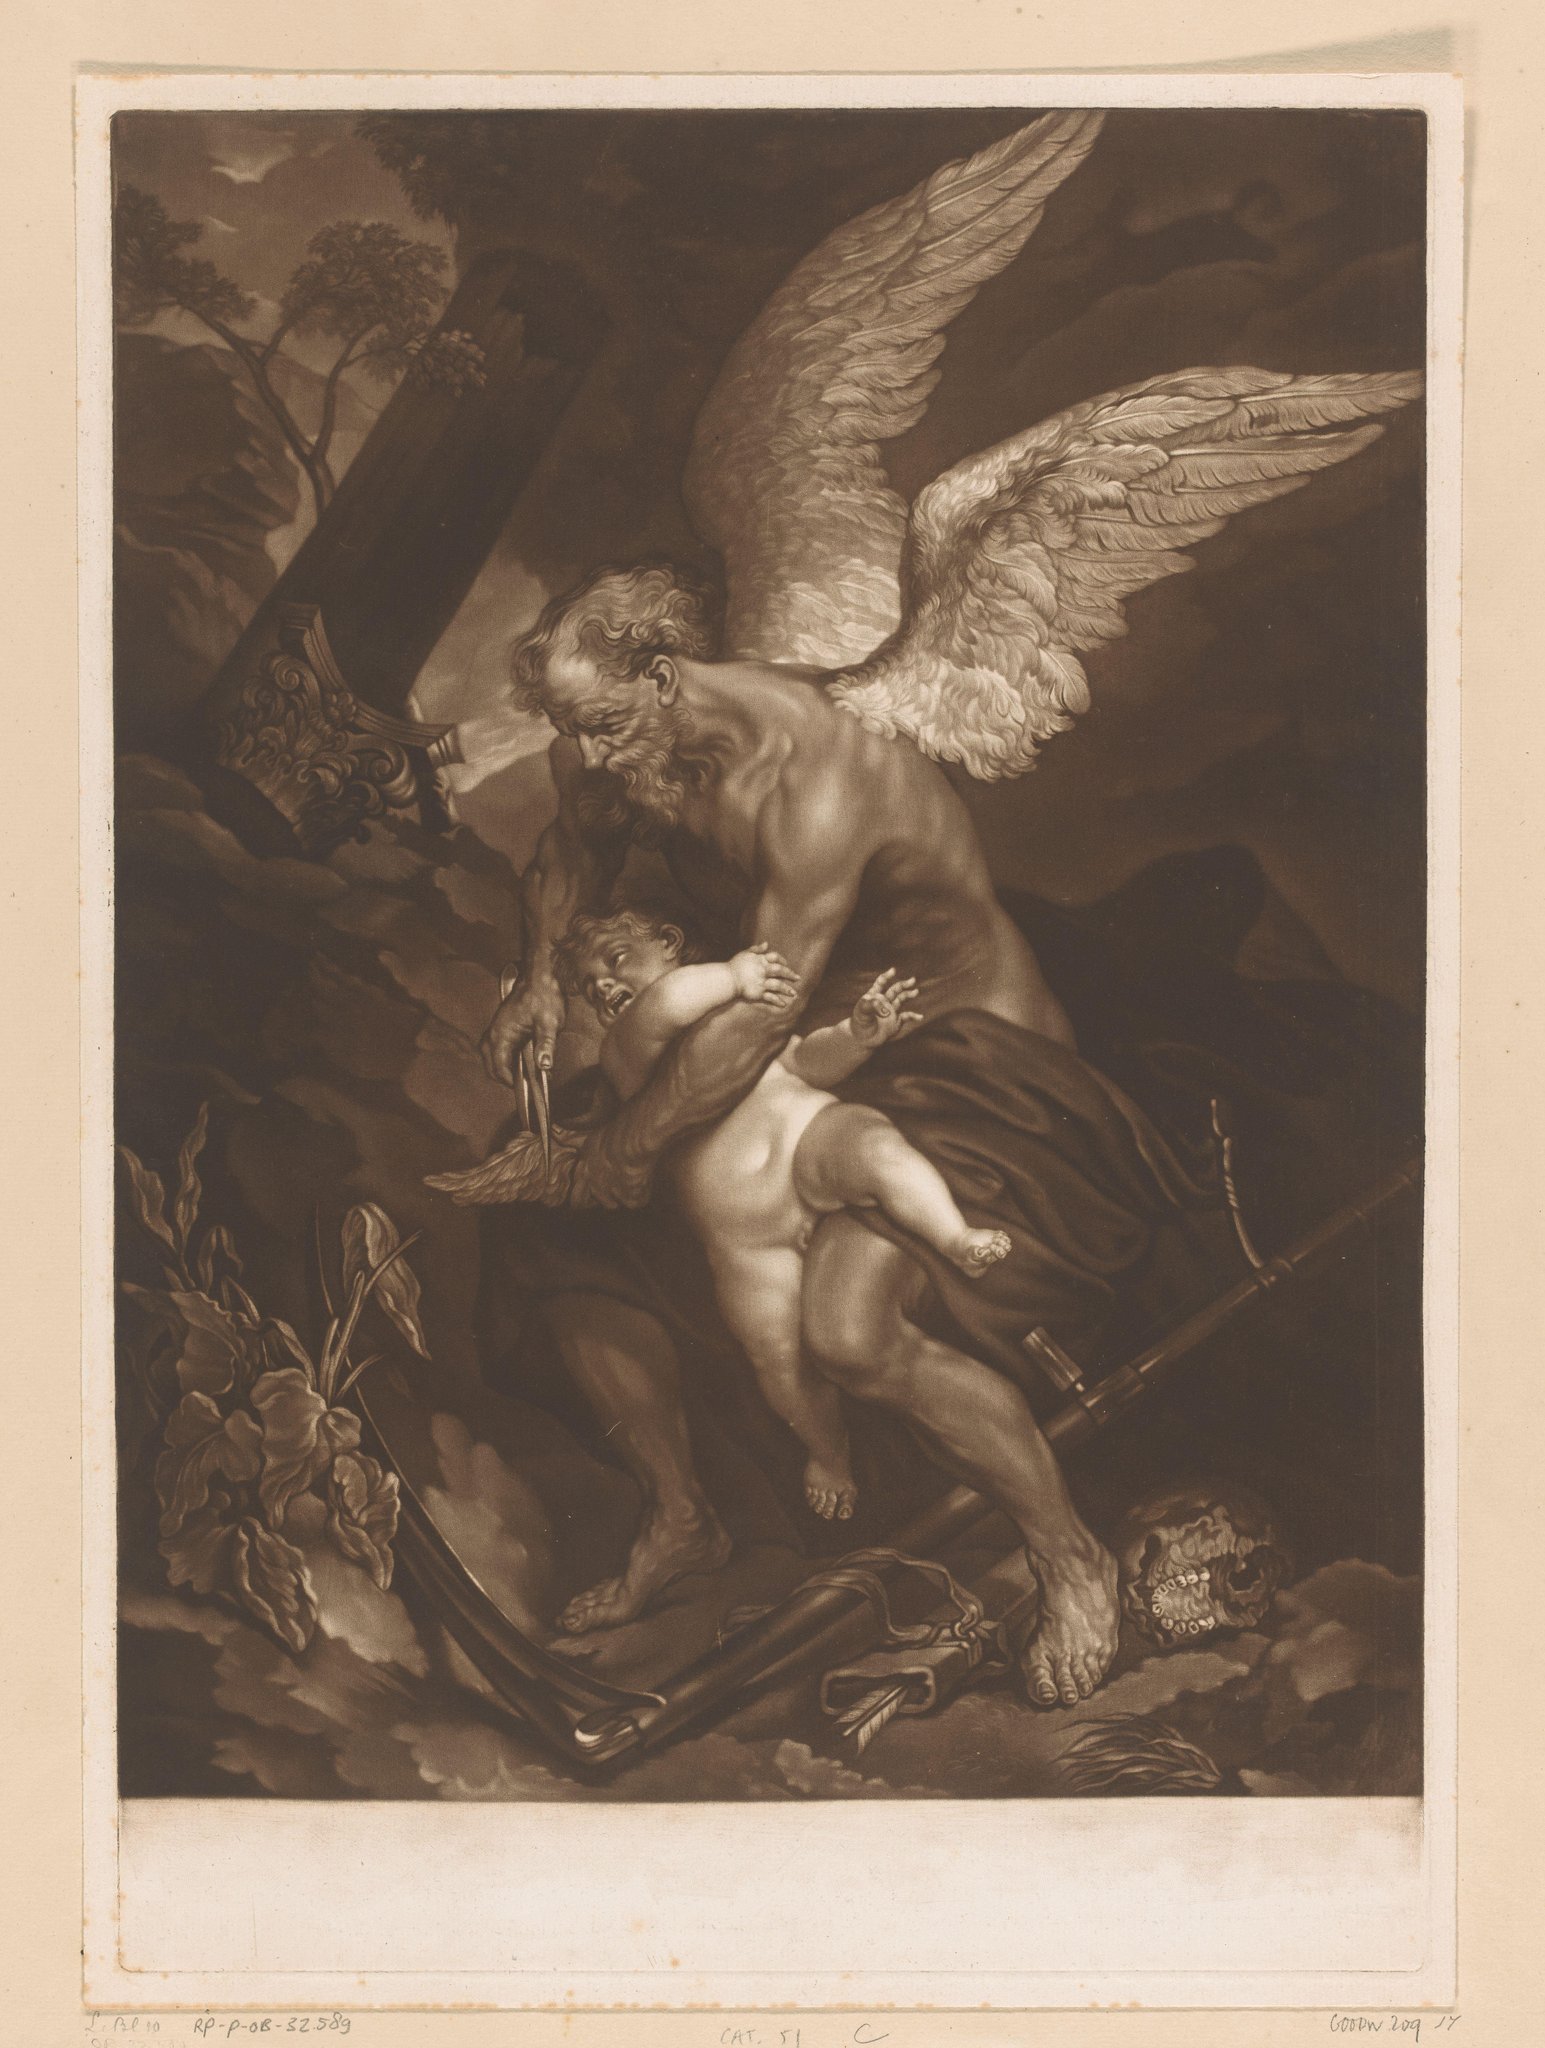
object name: print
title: Tijd knipt de vleugels van Cupido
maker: james mcardell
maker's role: print maker, publisher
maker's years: 1728-1765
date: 1745-1765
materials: paper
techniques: mezzotint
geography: london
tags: punishment of cupid, father time, man with wings and scythe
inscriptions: collector's mark: Lugt 240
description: Christopher Lennox-Boyd suggereert dat de prent beschreven onder Goodwin 209 bestaat uit drie verschillende platen, zie de beschrijving bij R,2.59 in het British Museum. Vooral de hier beschreven prent lijkt te verschillen van de eerste en derde staat beschreven bij Goodwin, vooral aan de onderkant van de voorstelling.